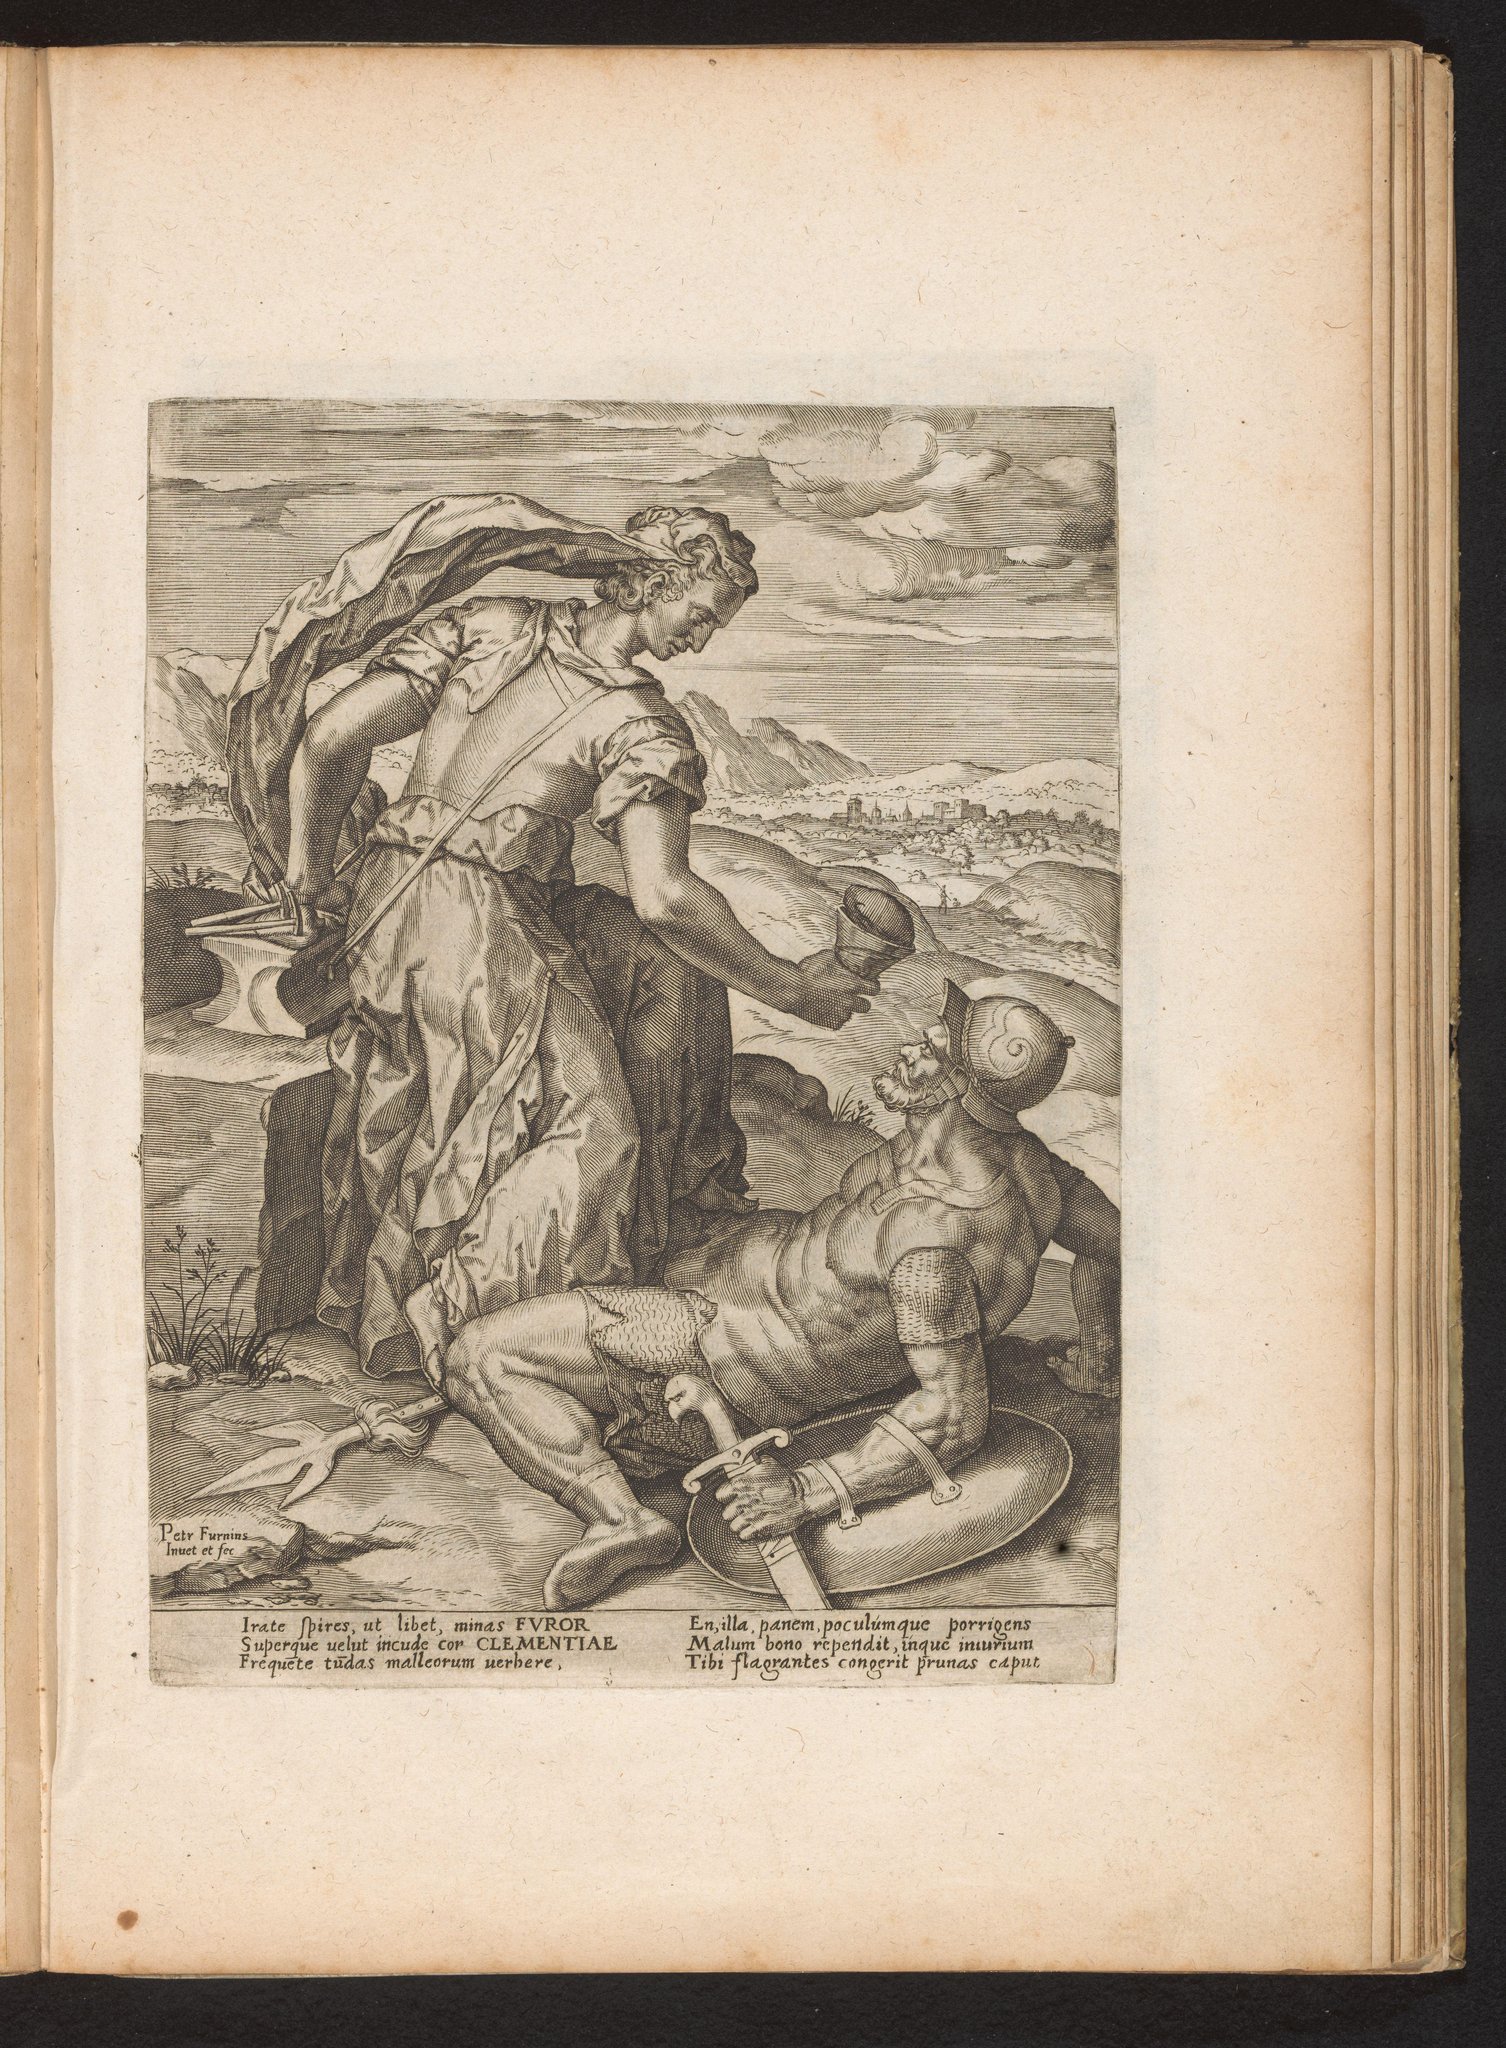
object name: album leaf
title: Zachtmoedigheid overwint Razernij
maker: pieter jalhea furnius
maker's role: print maker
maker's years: 1540-1626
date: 1550-1625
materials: paper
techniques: engraving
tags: anger; 'ira' (ripa) ~ personification of one of the seven deadly sins, one virtue fighting against or treading upon one vice, tools, aids, implements ~ crafts and industries: anvil, indulgence, clemency; 'clemenza', 'clemenza & moderatione', 'indulgenza' (ripa)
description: De Zachtmoedigheid heeft de Razernij overwonnen en geeft de verslagen soldaat een glas drinken. De Zachtmoedigheid steunt op een aambeeld. Deze prent maakt deel uit van een album.